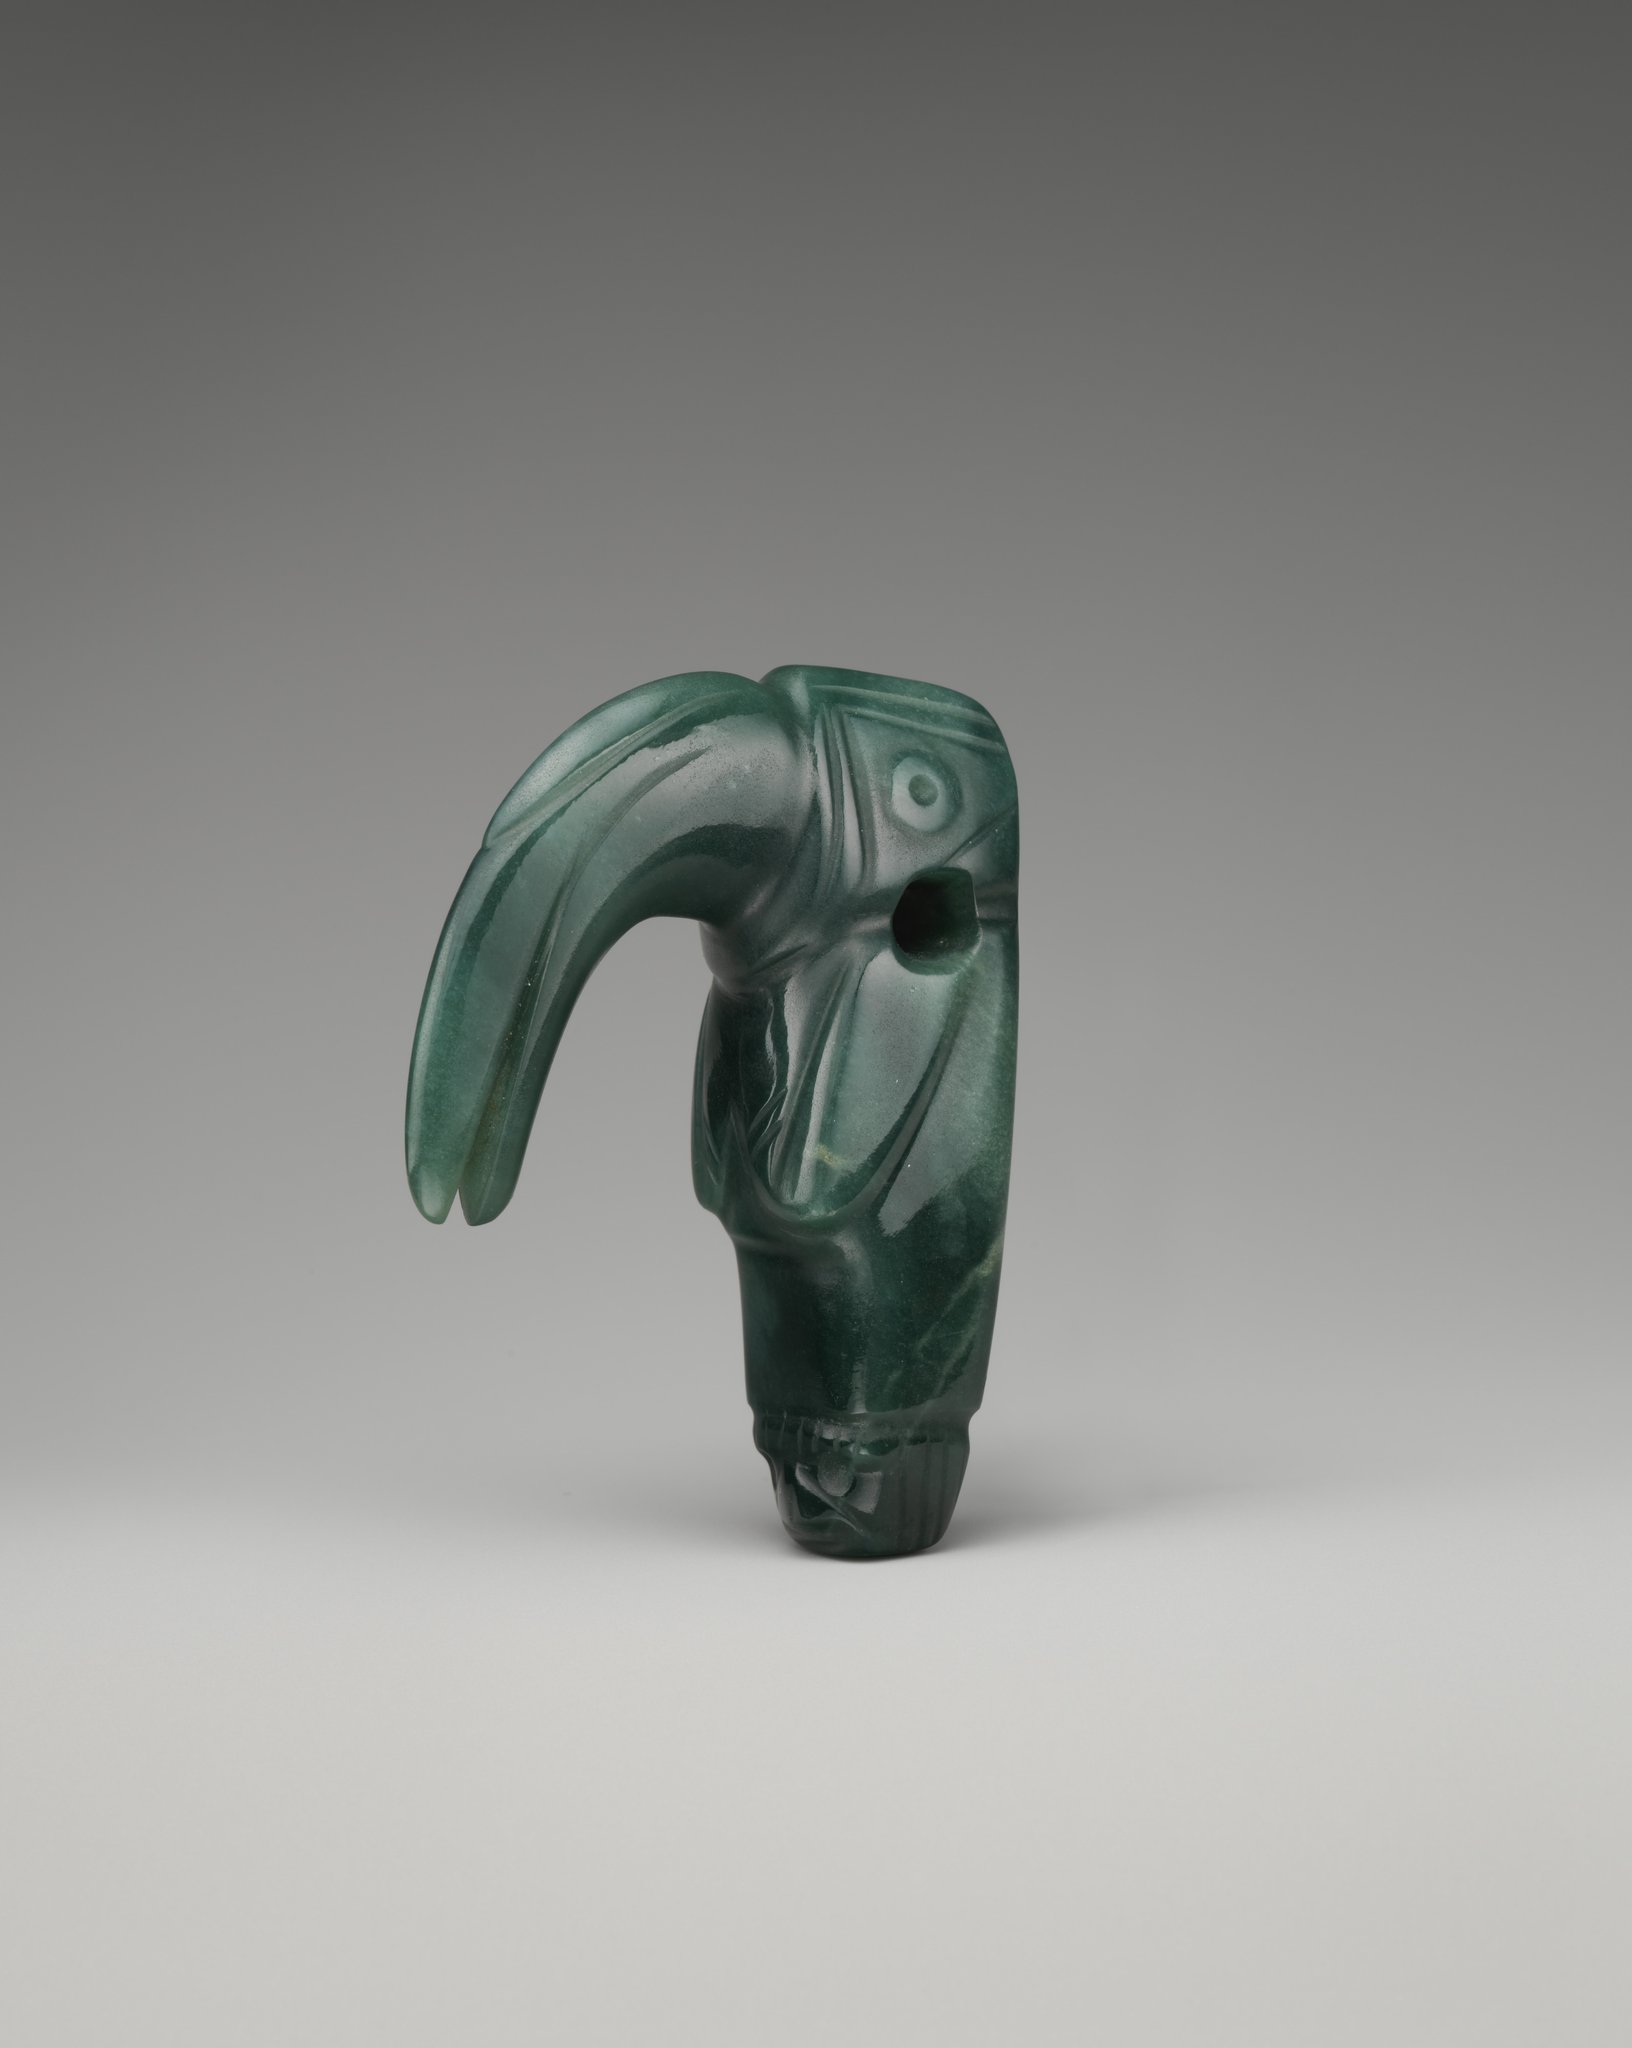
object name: pendant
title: Bird pendant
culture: central region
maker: central region artist(s)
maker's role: artist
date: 300-700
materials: jade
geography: costa rica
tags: birds